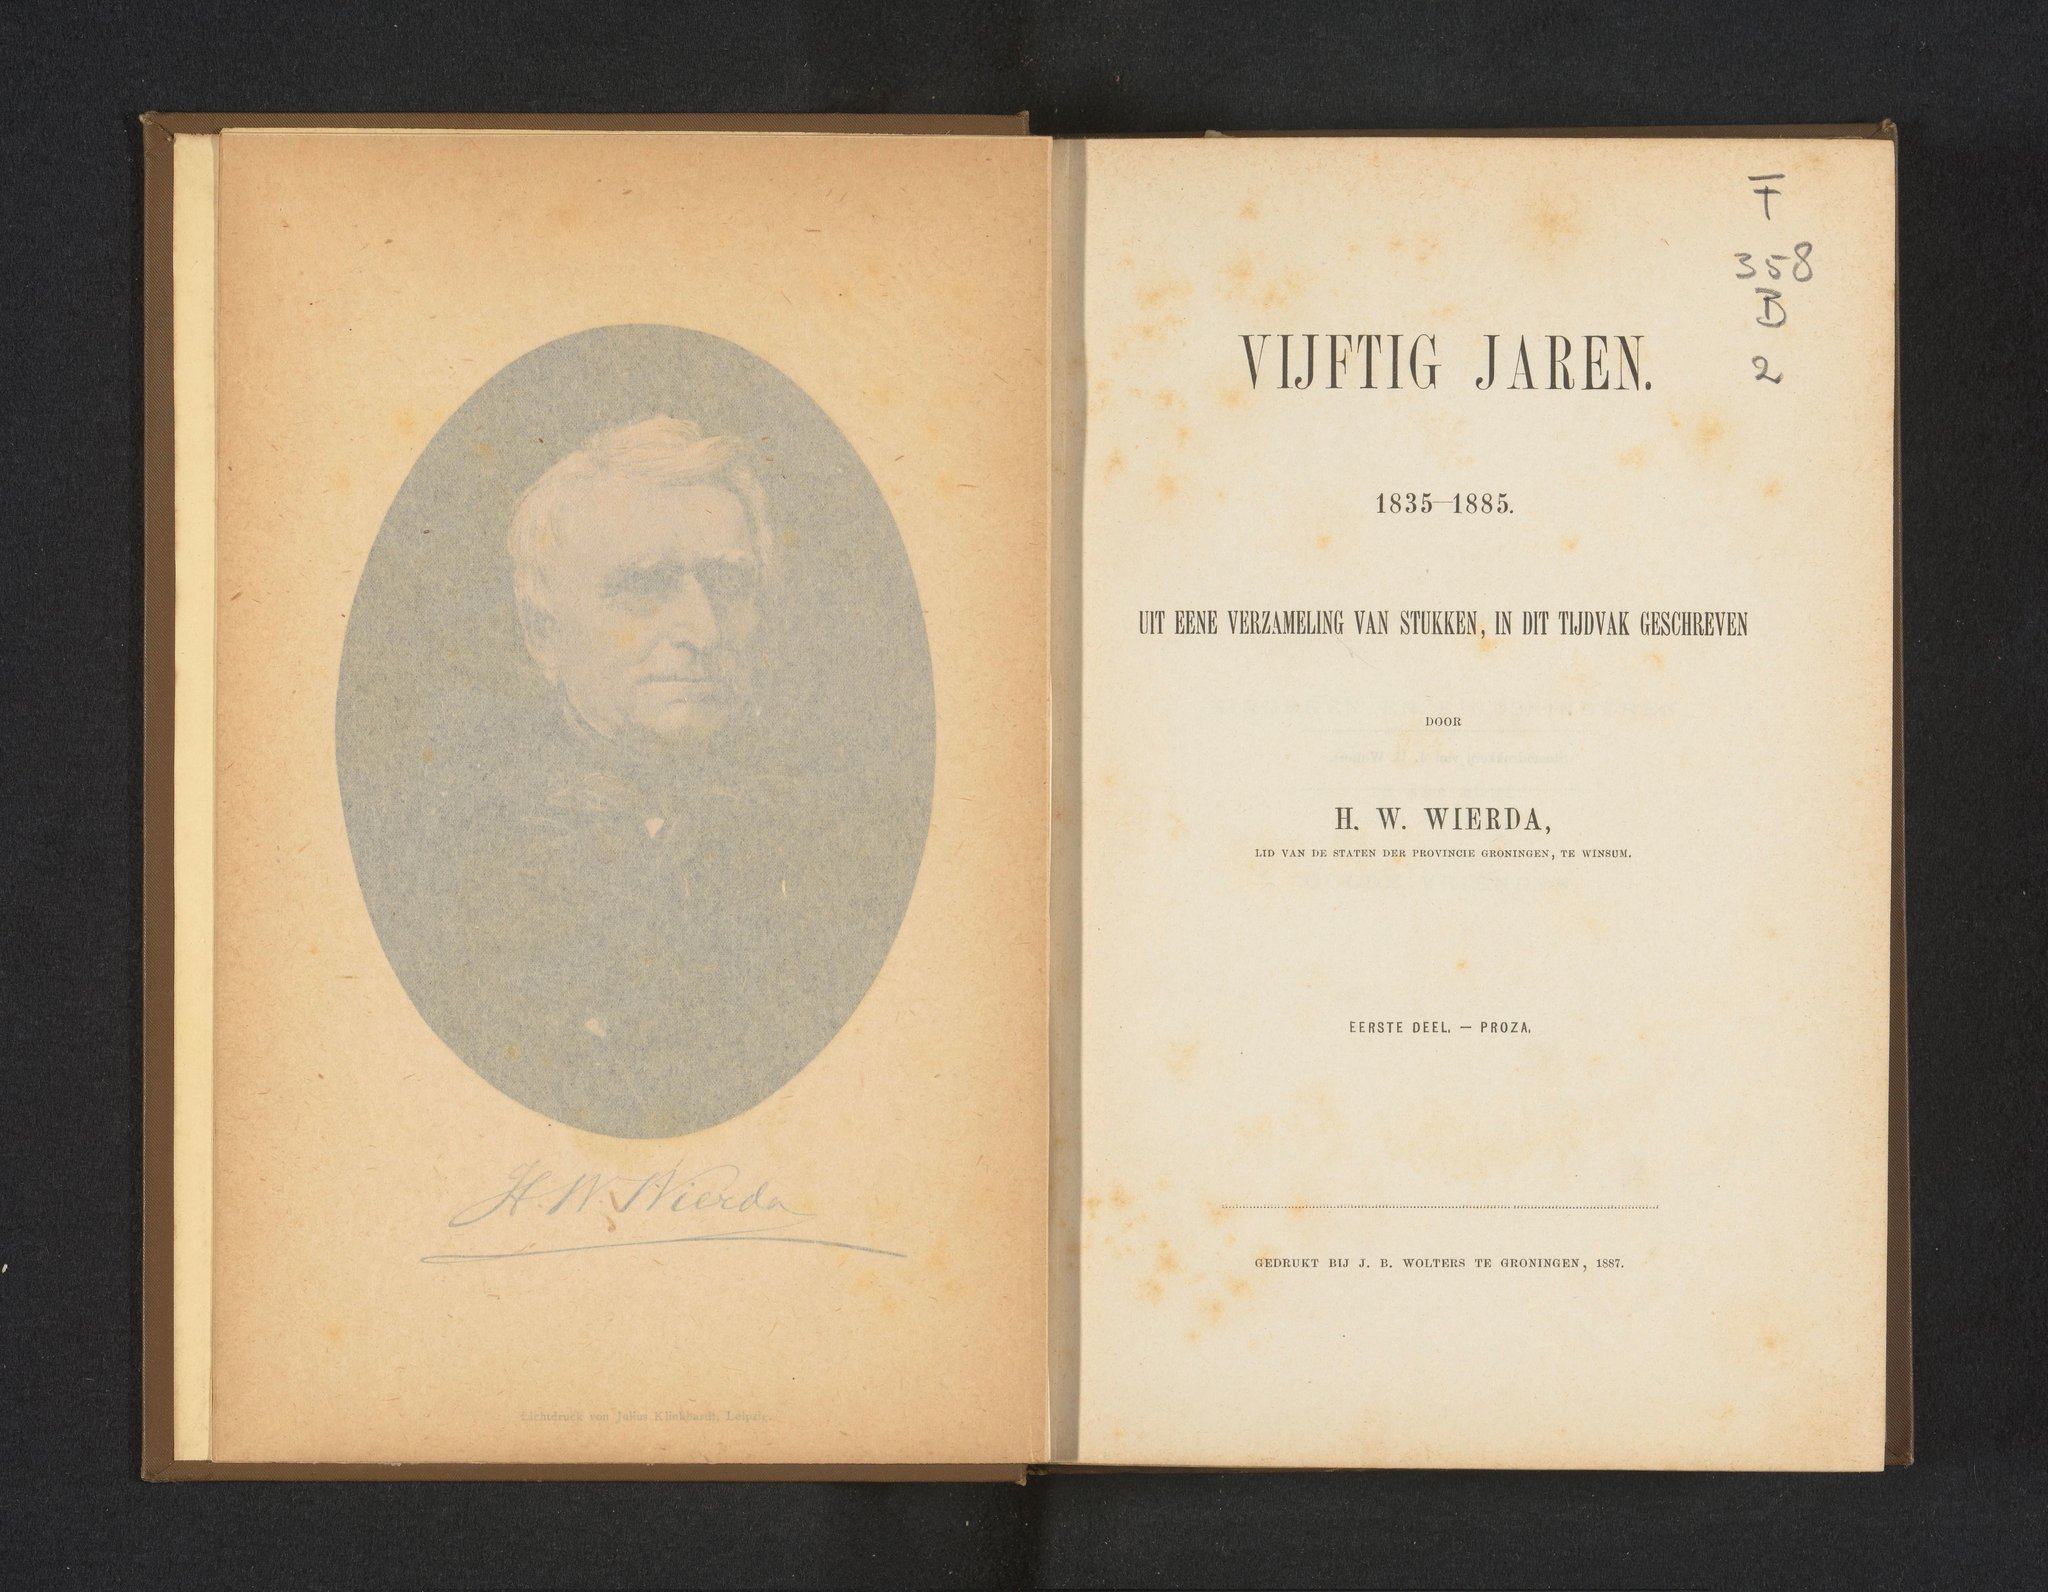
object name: book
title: Vijftig jaren: 1835-1885: uit eene verzameling van Stukken, in dit tijdvak geschreven/ door H.W. Wierda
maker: h.w. wierda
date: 1887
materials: cardboard, linen, paper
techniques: photograph, printing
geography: groningen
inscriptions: annotation: ‘APR/ 2000’